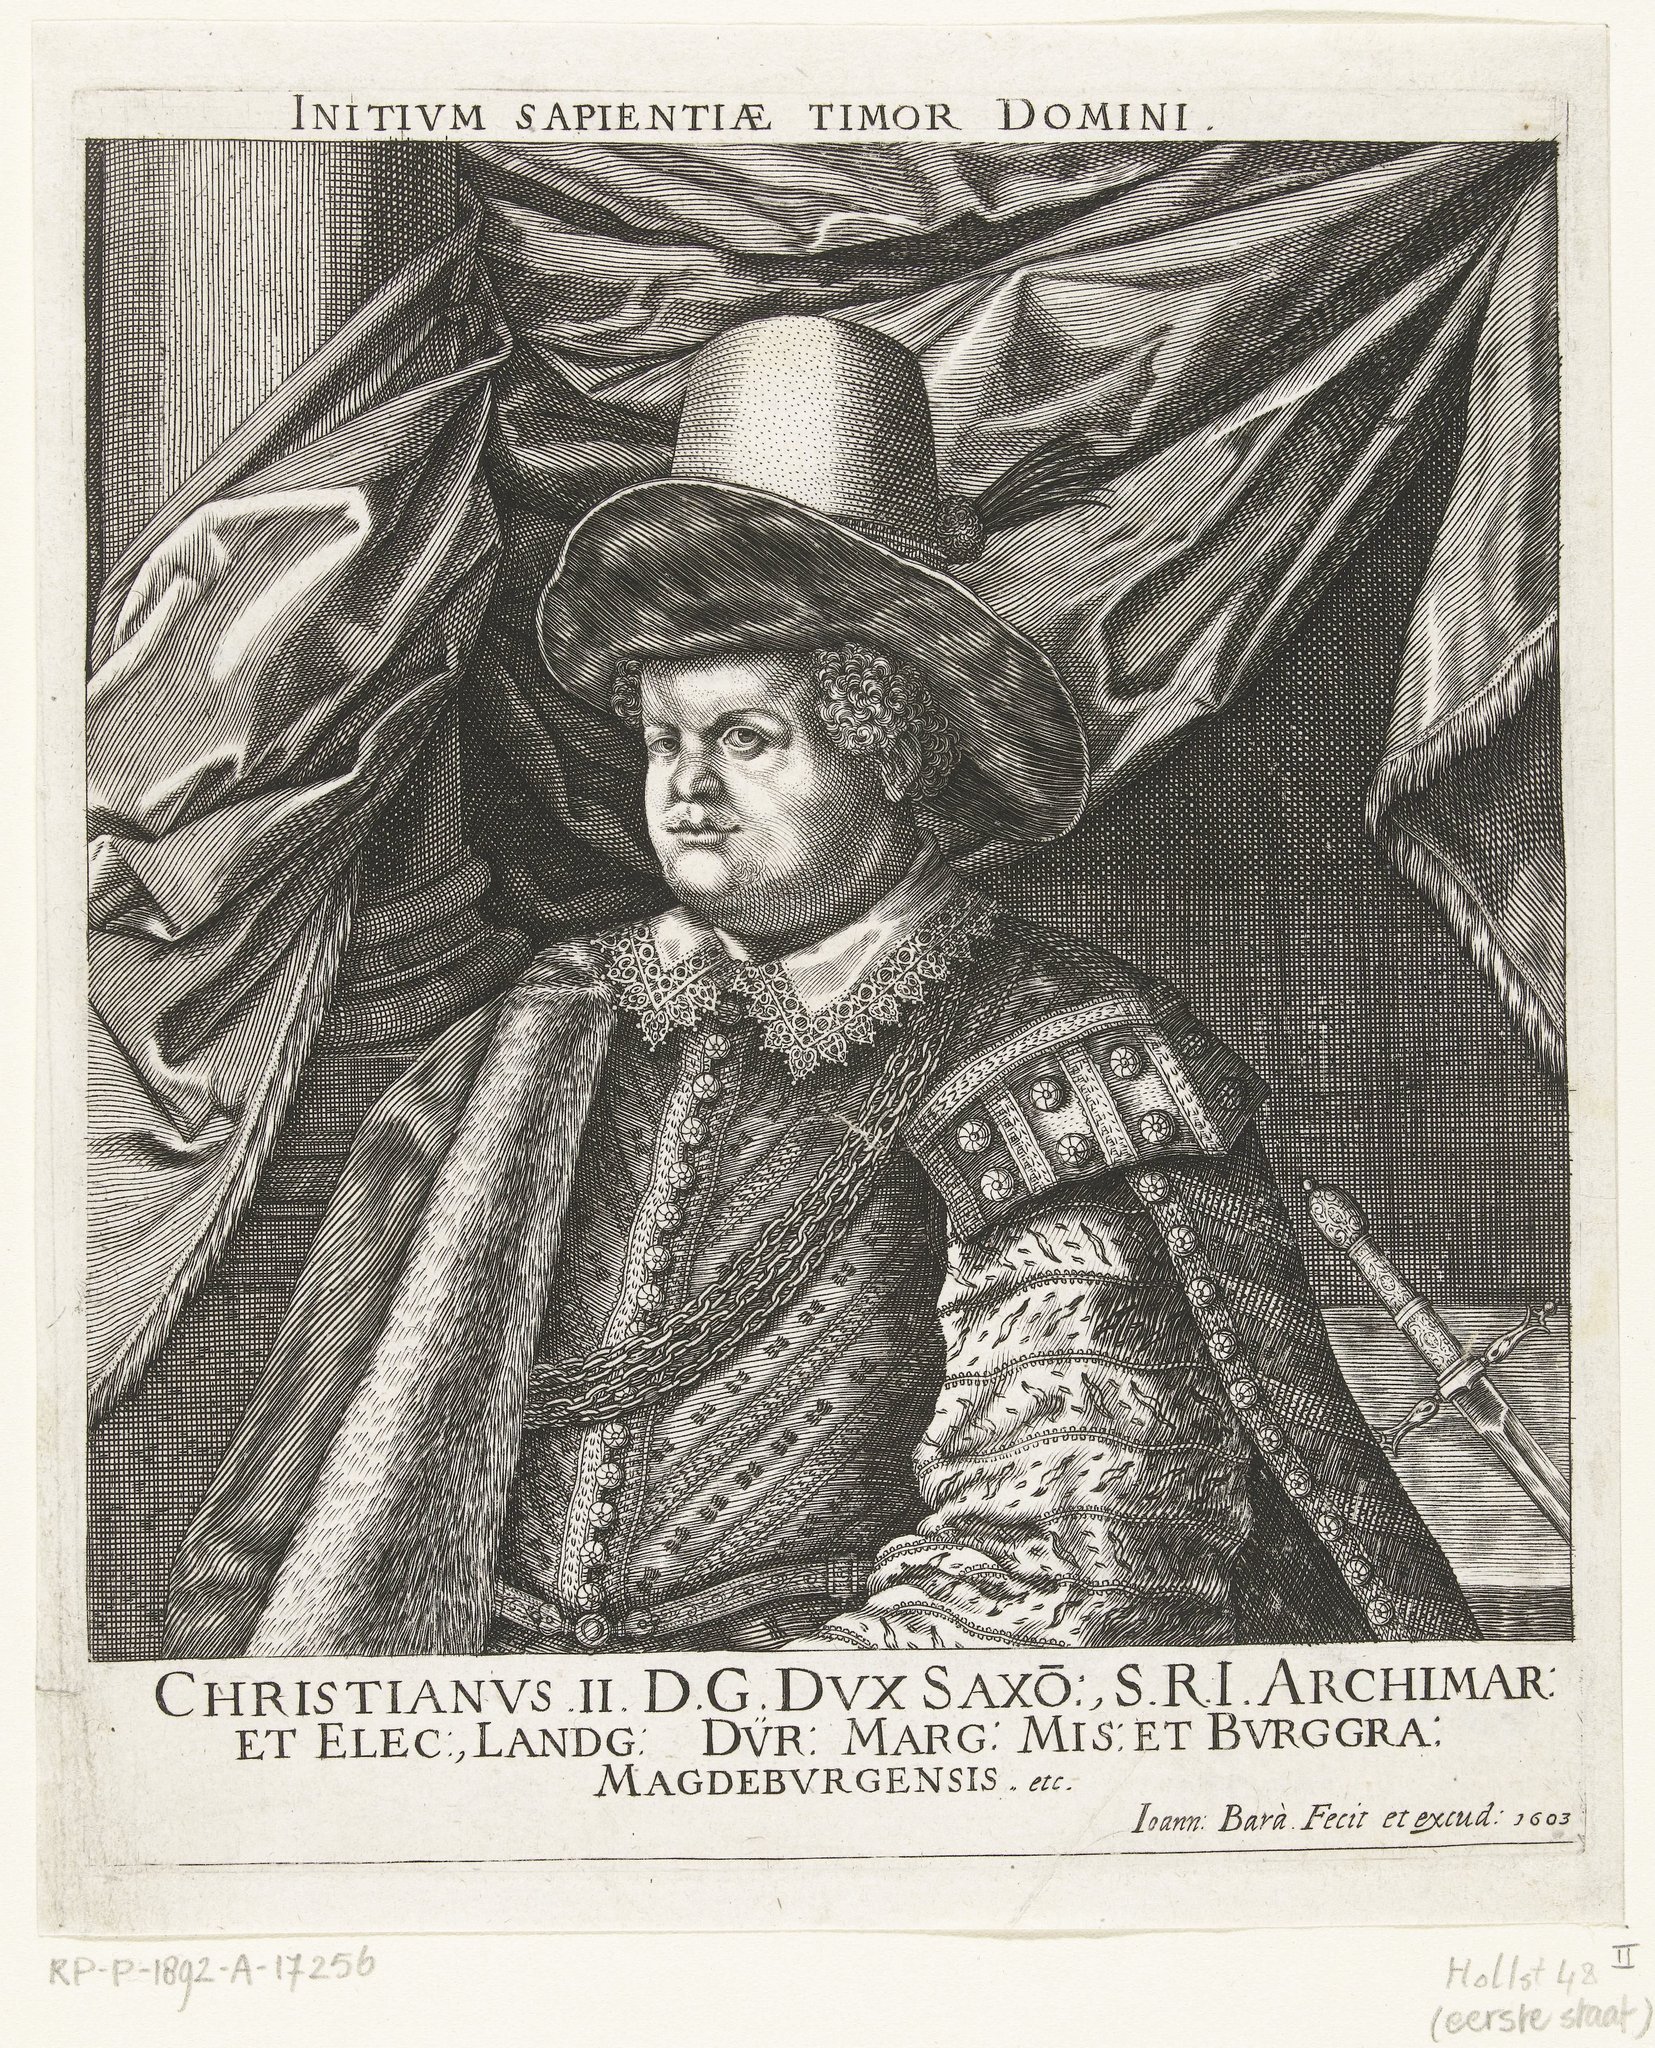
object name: print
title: Portret van Christiaan II keurvorst van Saksen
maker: johan barra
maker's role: print maker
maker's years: 1581-1634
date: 1603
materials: paper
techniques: engraving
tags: head-gear (with name)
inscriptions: date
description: Hollstein beschrijft de twee staten niet goed. Deze prent is gedrukt in de eerste staat voor de wijziging van de naam van Christiaan II in Augustus II en toevoeging van het Engelse opschrift en de baard van de man.